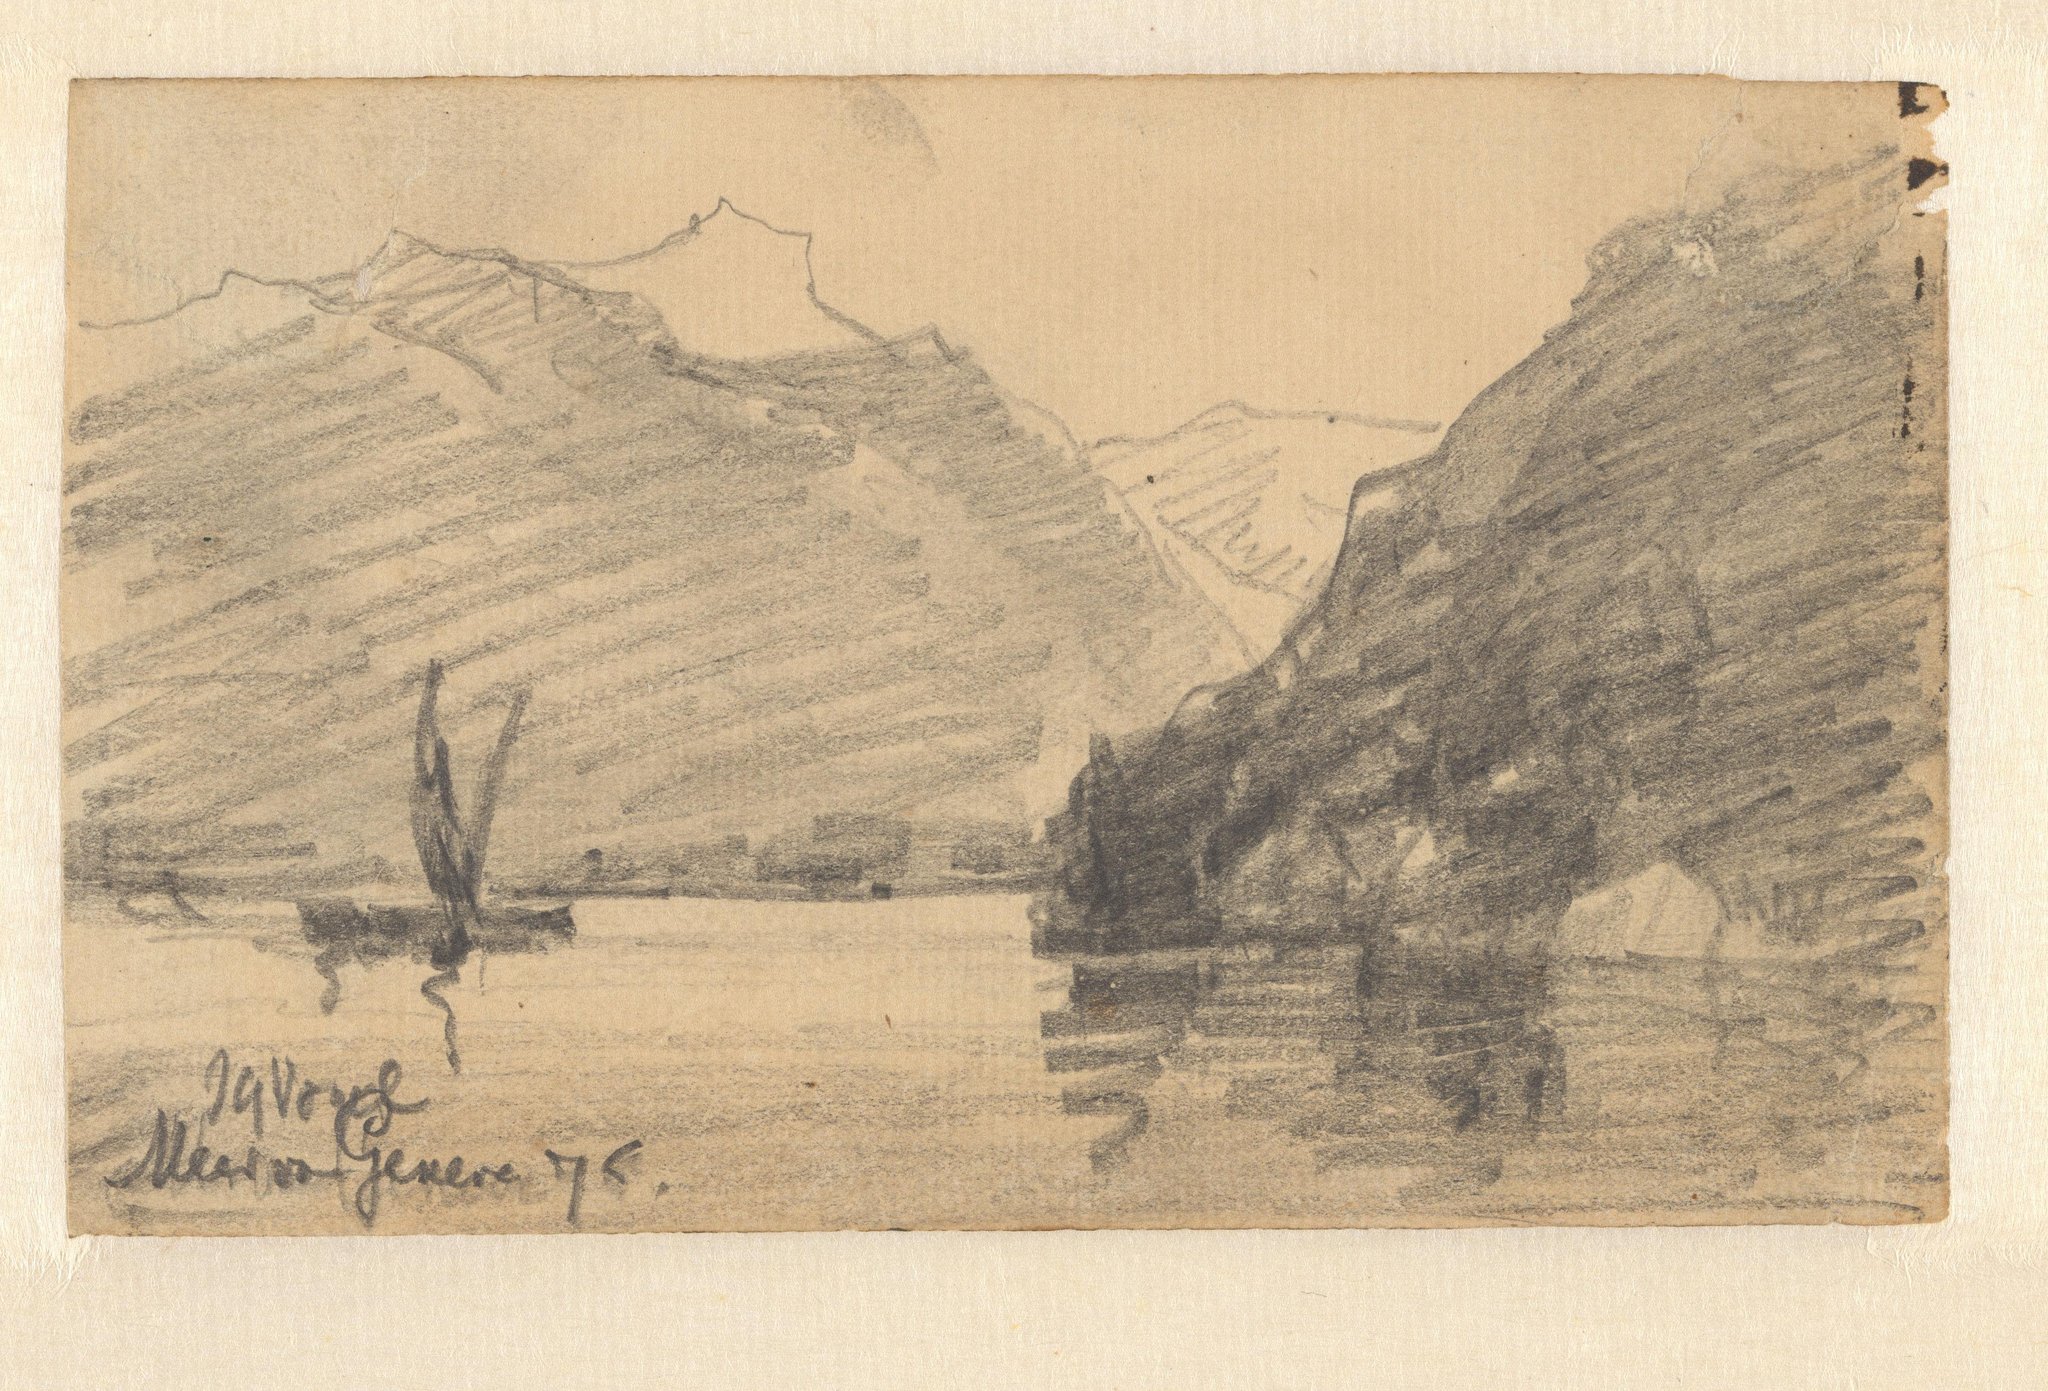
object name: drawing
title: Gezicht op het Meer van Genève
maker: johannes gijsbert vogel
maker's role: draughtsman, painter, print maker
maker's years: 1828-1915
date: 1875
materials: paper, pencil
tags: lake, mountains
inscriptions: date and inscription: ‘Meer van Geneve 75’, collector's mark: Lugt 1181b